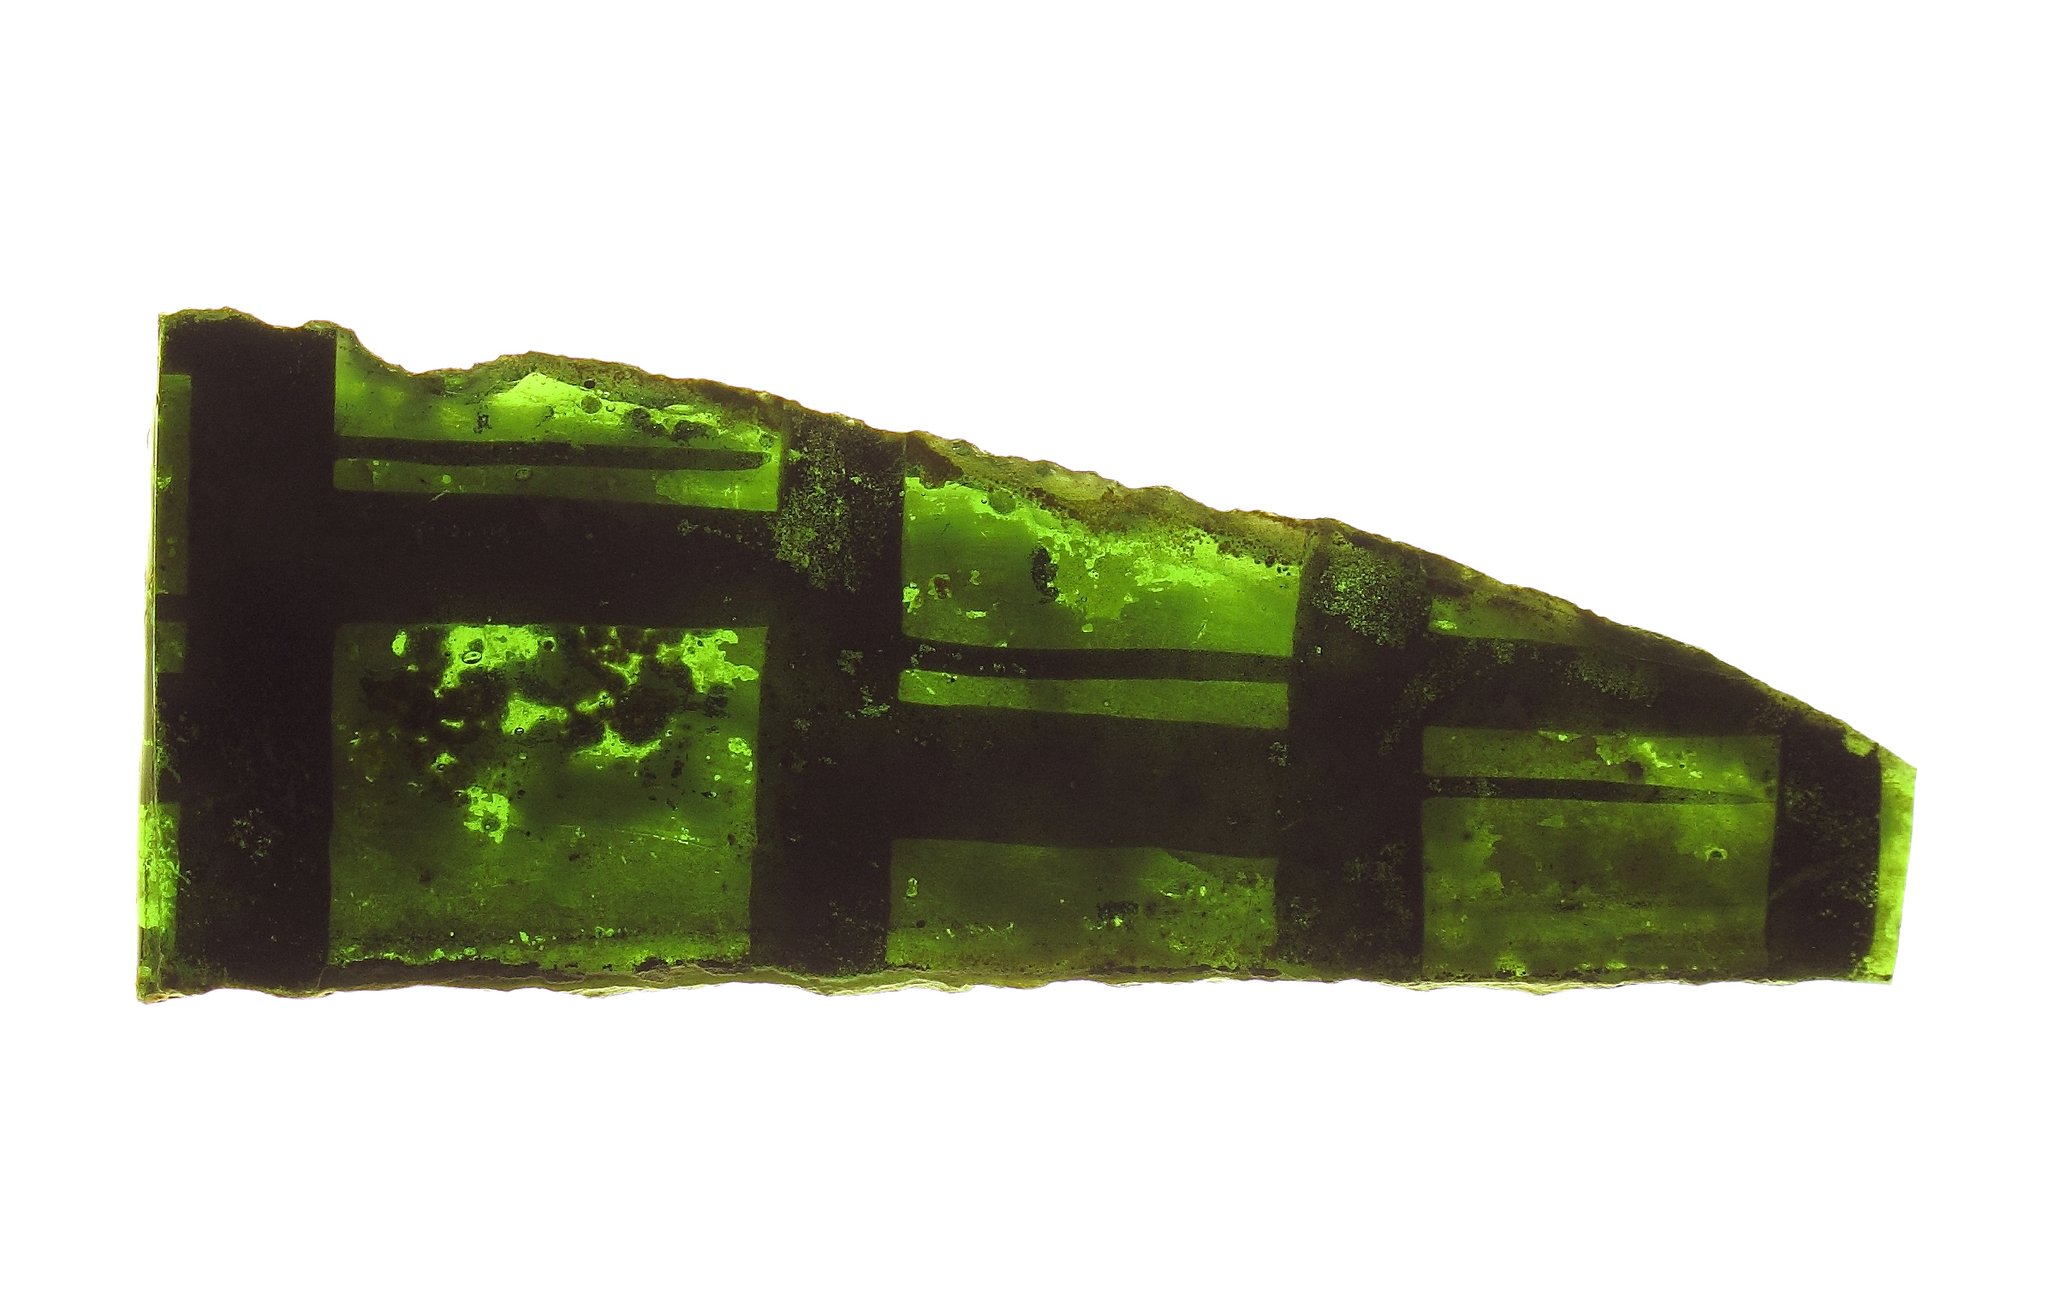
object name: fragment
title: Glass Fragment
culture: french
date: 1201-1300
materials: glass, metal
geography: france